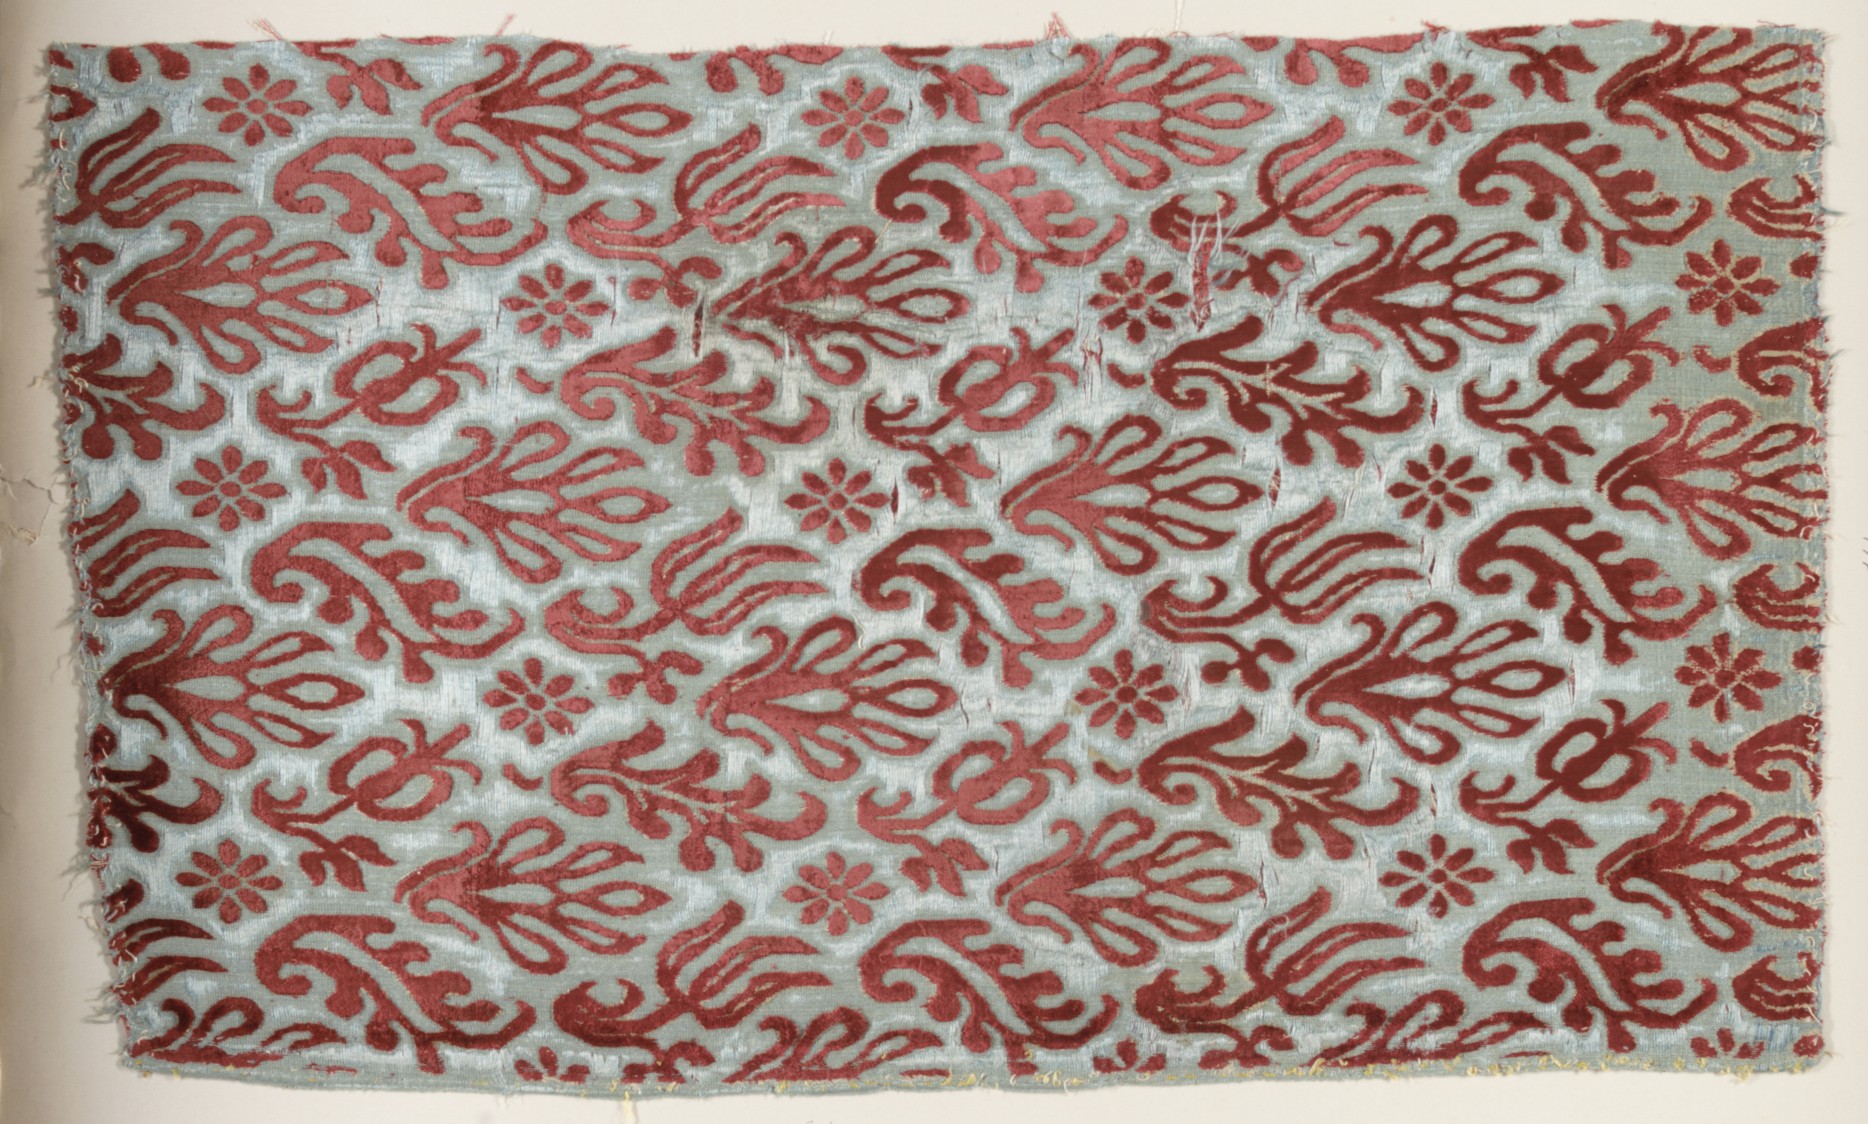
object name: fragment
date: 1501-1700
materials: silk